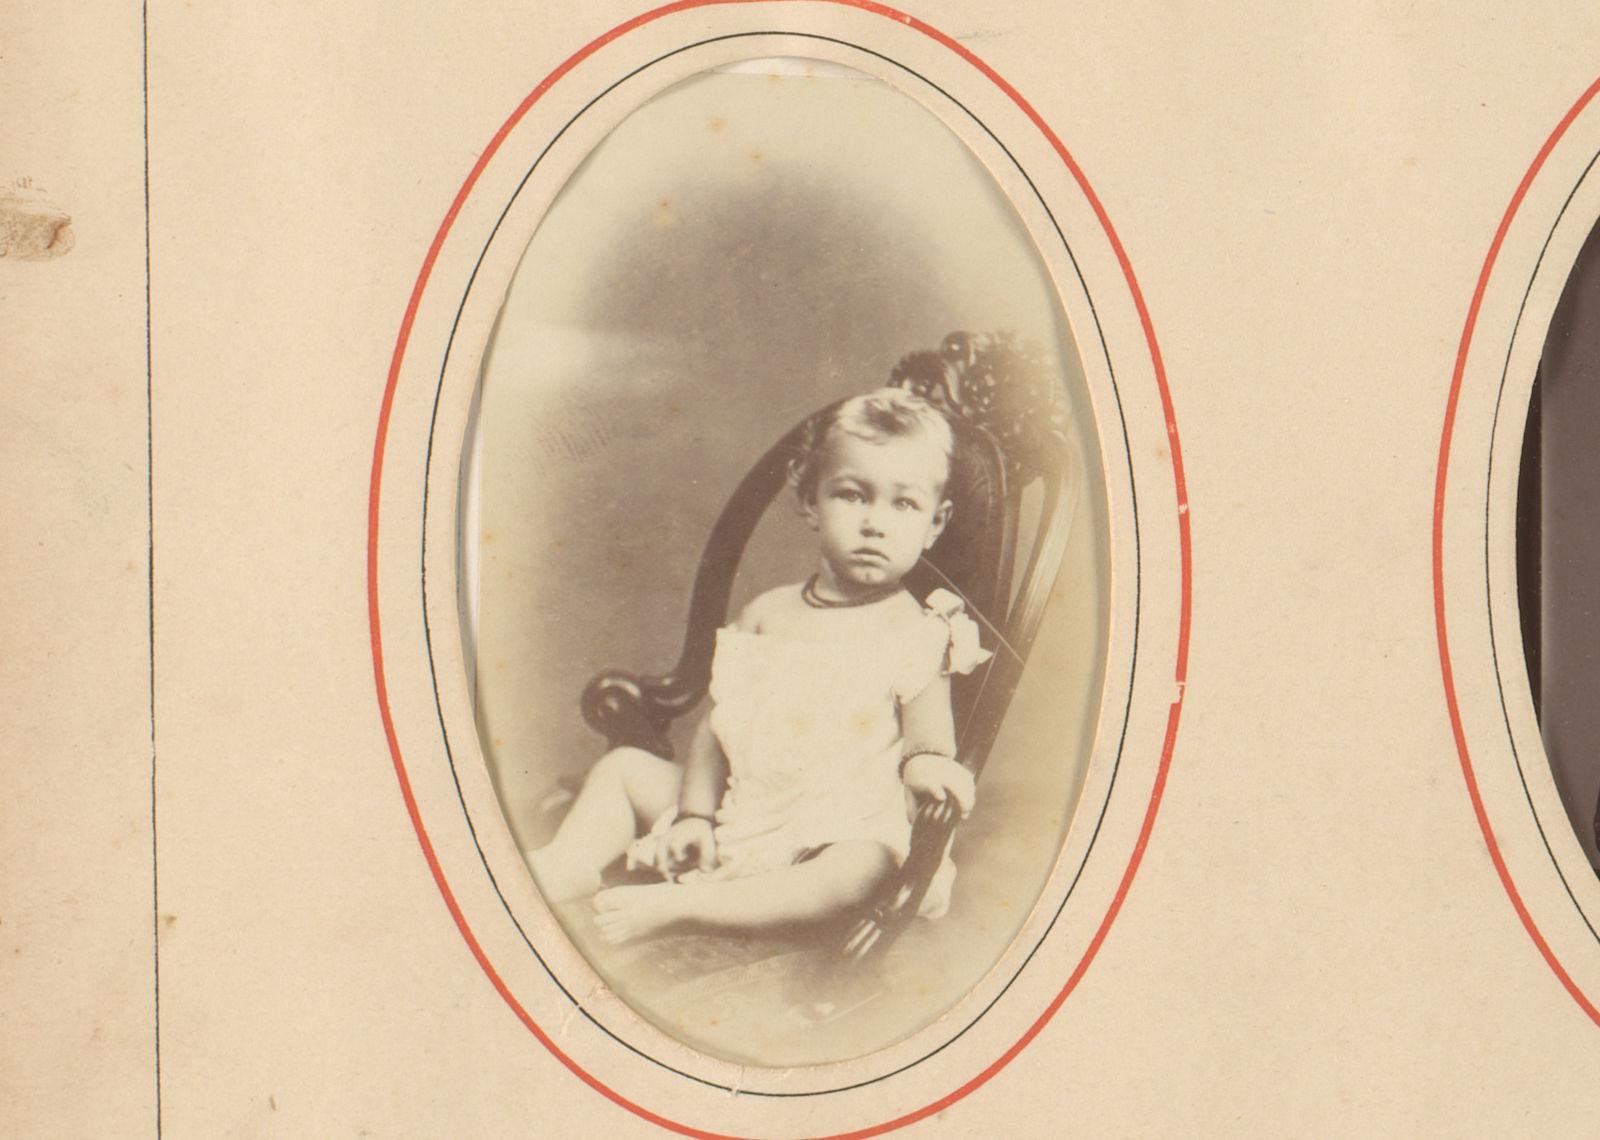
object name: carte de visite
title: Portret van een onbekend kind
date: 1871-1890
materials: cardboard, paper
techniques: albumen print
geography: batavia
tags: anonymous historical person portrayed